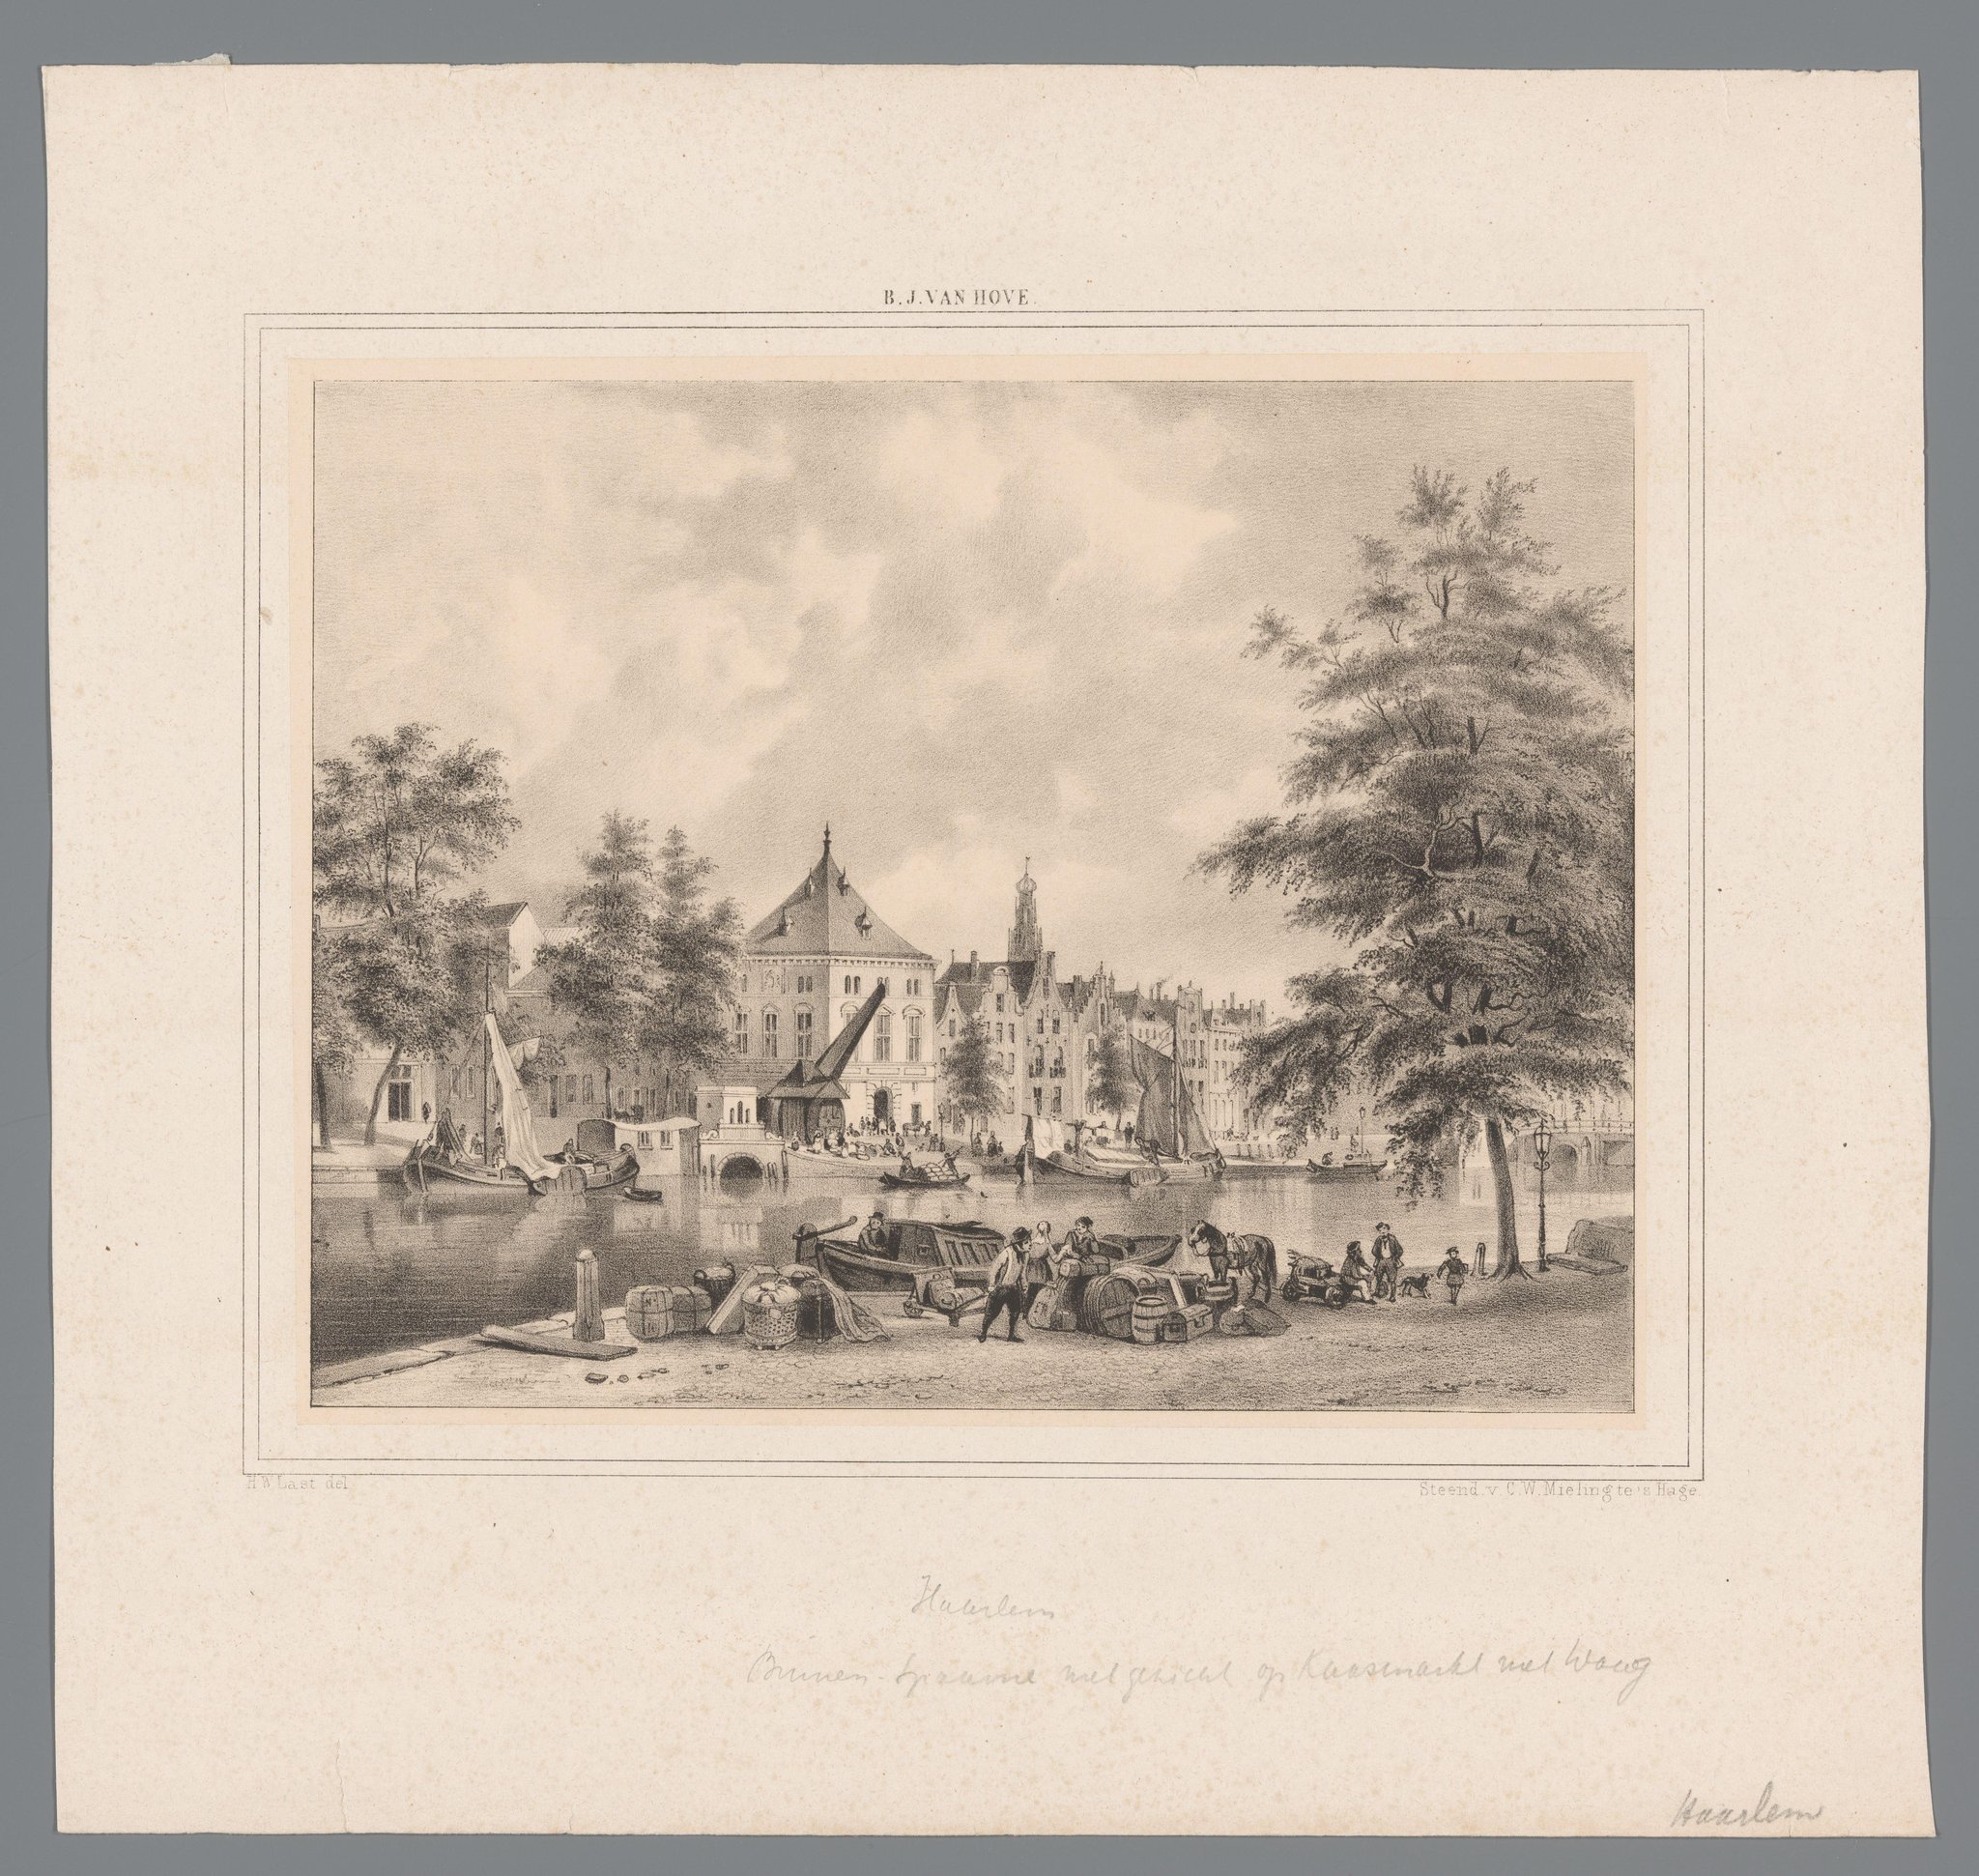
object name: print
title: Stadsgezicht op het Spaarne en de Waag in Haarlem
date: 1846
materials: paper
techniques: lithograph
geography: the hague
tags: sailing-ship, sailing-boat, canals, waters (in city), dock crane, weigh-house, haarlem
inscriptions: collector's mark: Lugt 2228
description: Prent uit: Kunstkronijk, zevende jaar. Den Haag: K. Fuhri, 1846, p. 88-89.